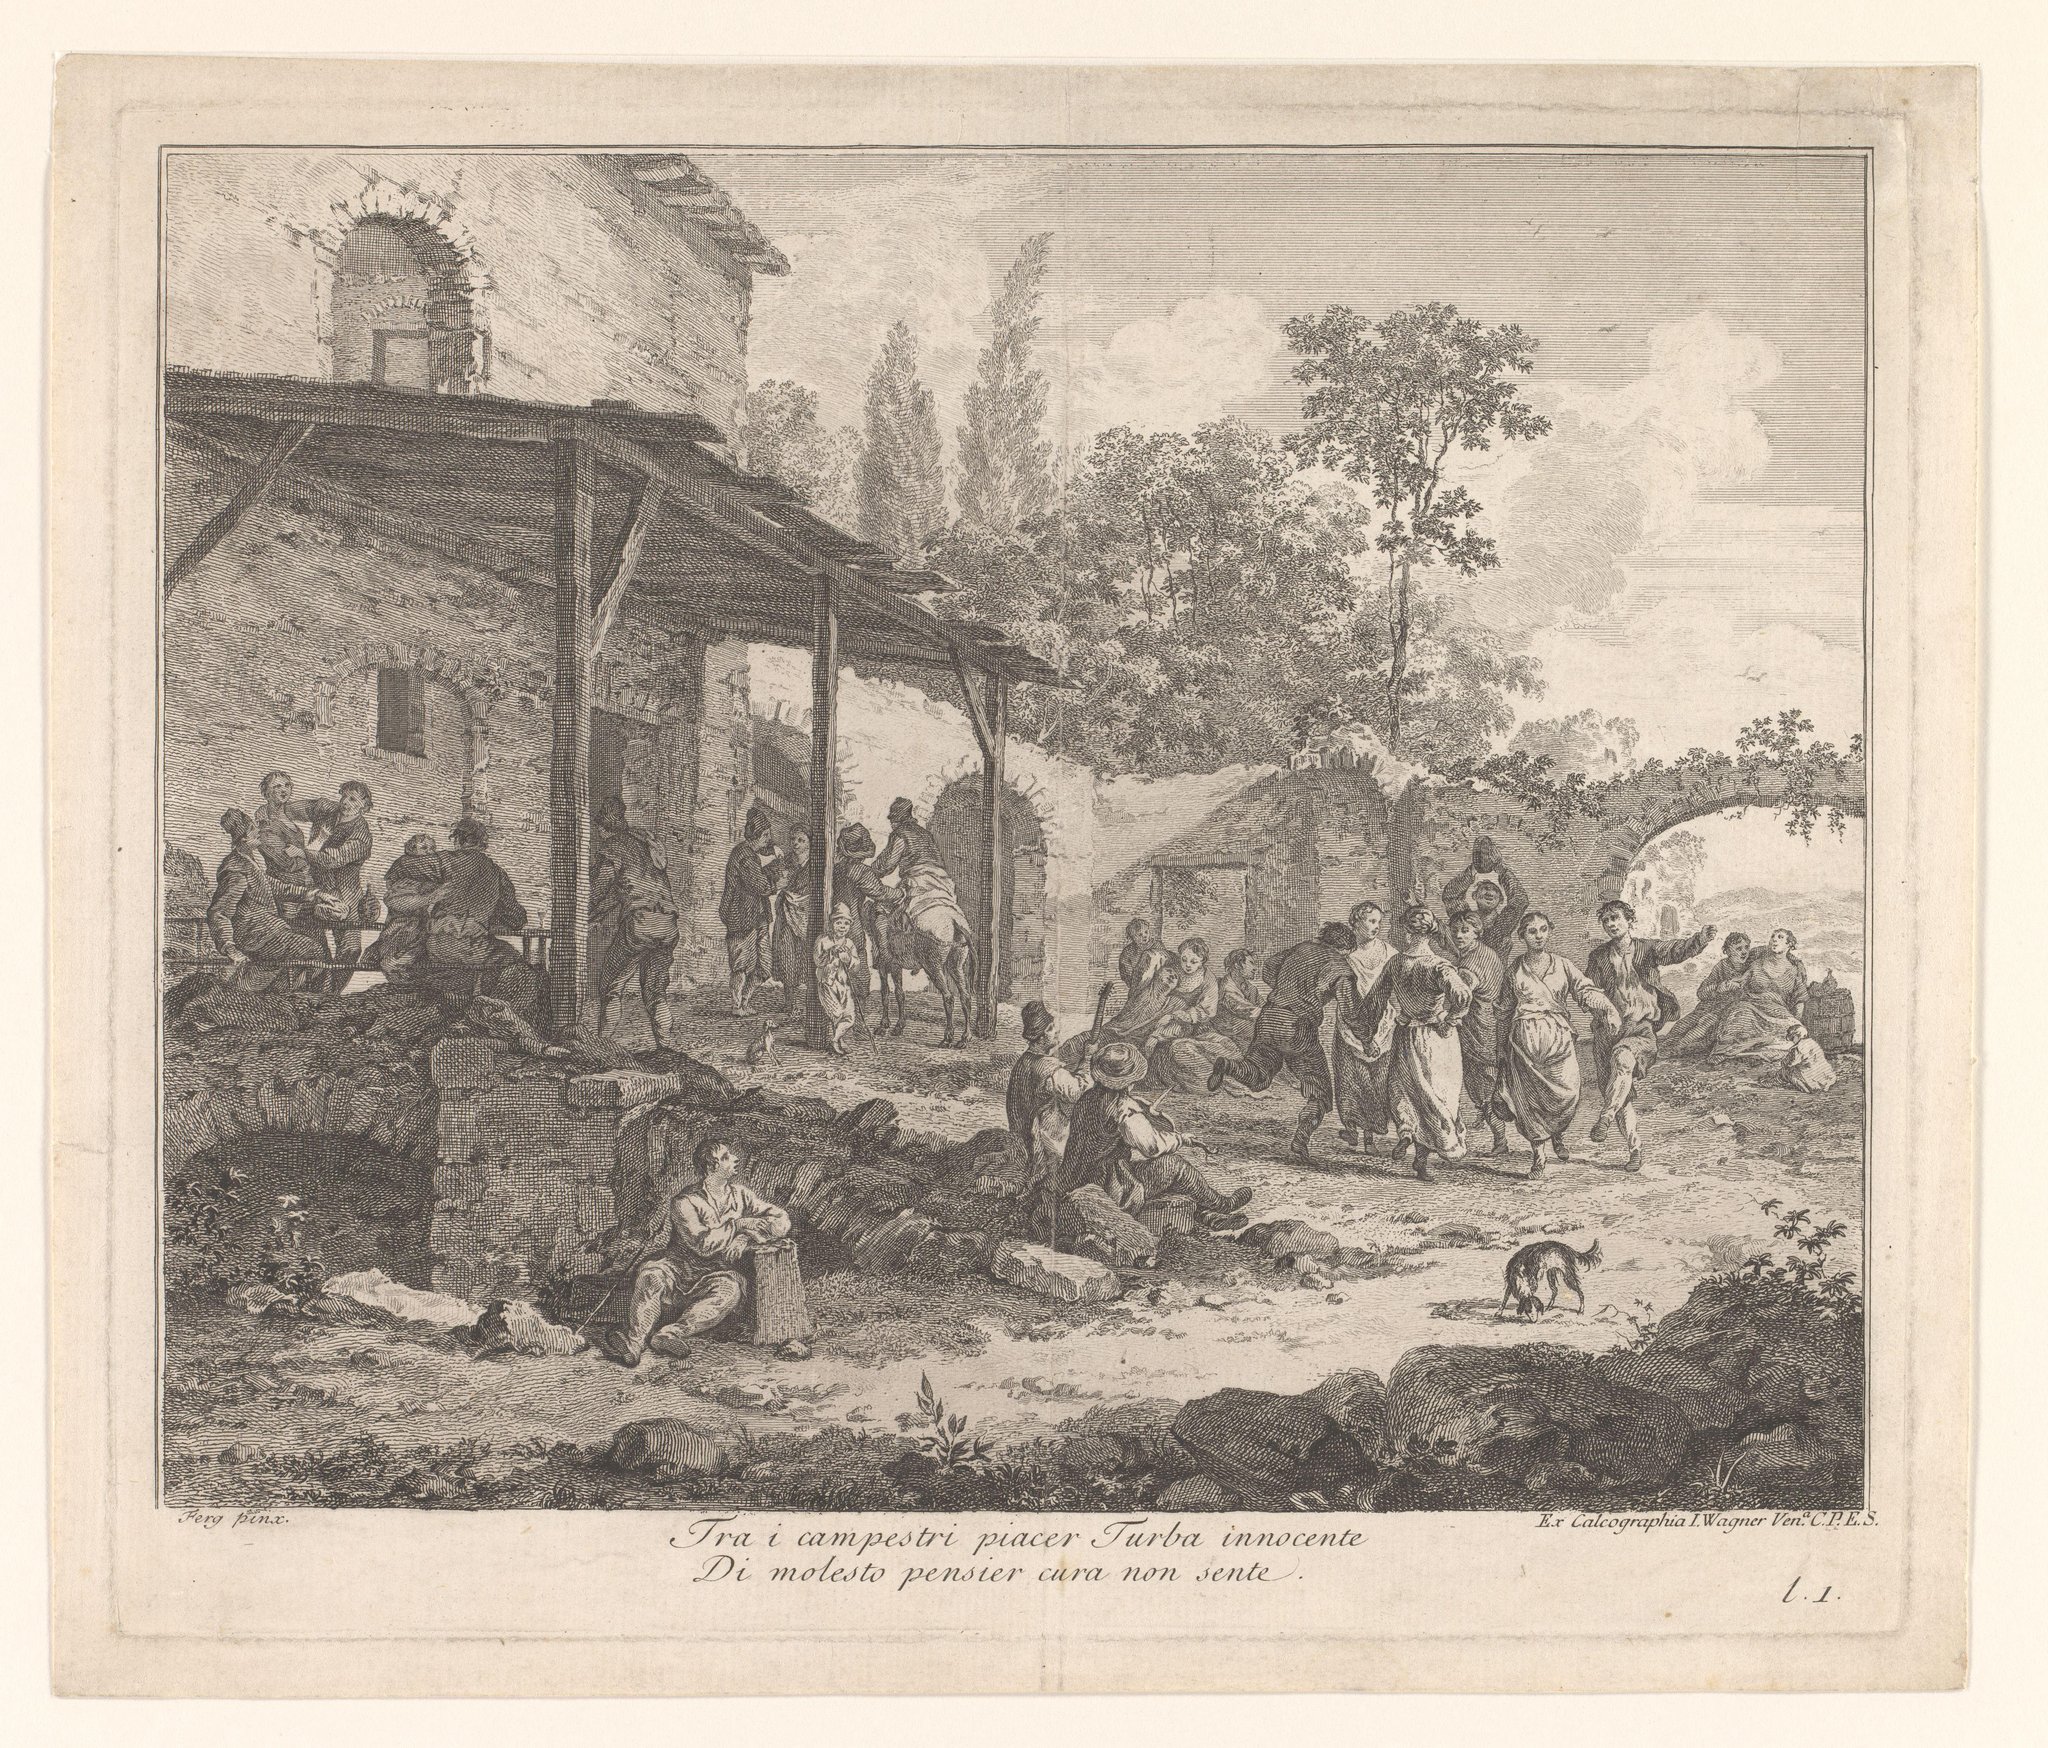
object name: print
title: Boerenfeest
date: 1739-1780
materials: paper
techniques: engraving, etching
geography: venice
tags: landscapes, farmers, violin, fiddle - cc - out of doors, group dancing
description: Met tweeregelig onderschrift in het Italiaans. Rechtsonder genummerd: l.1.